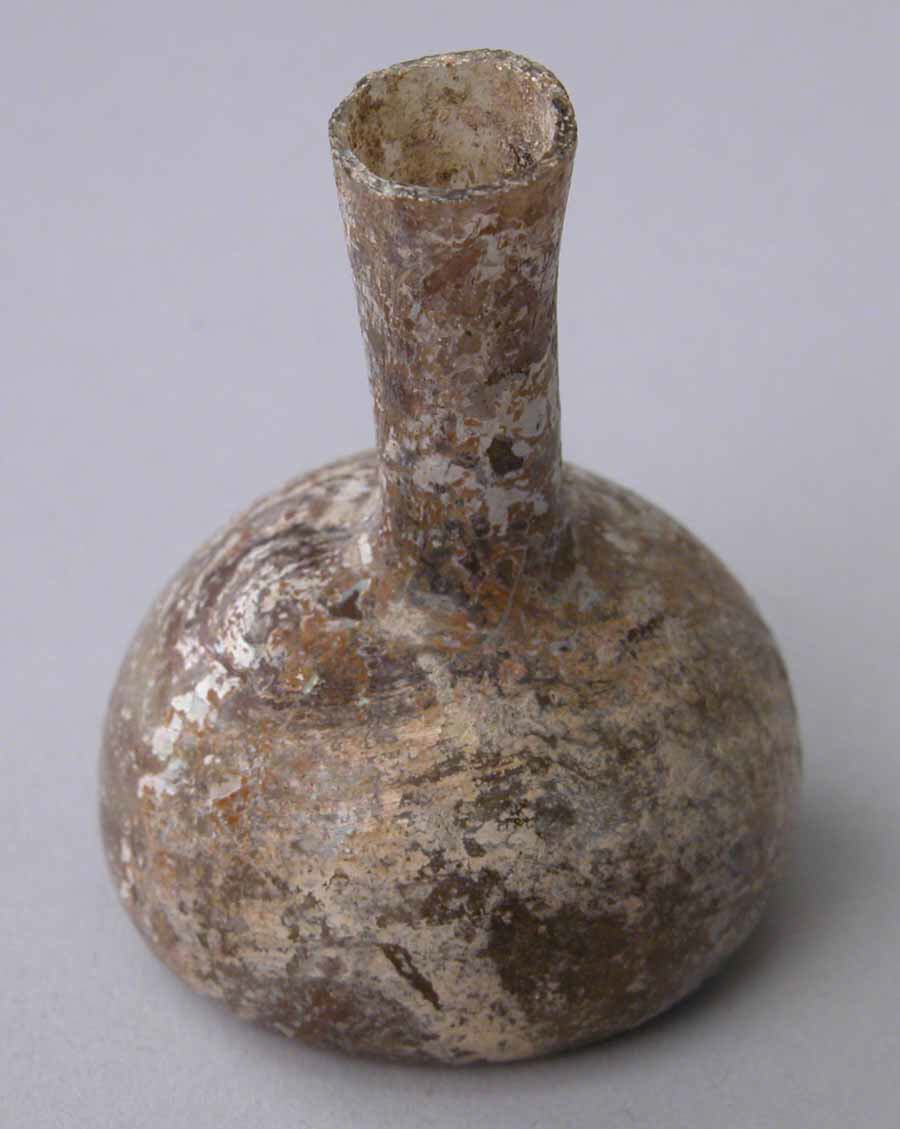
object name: bottle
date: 601-800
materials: glass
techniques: glassblowing, tooling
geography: iraq